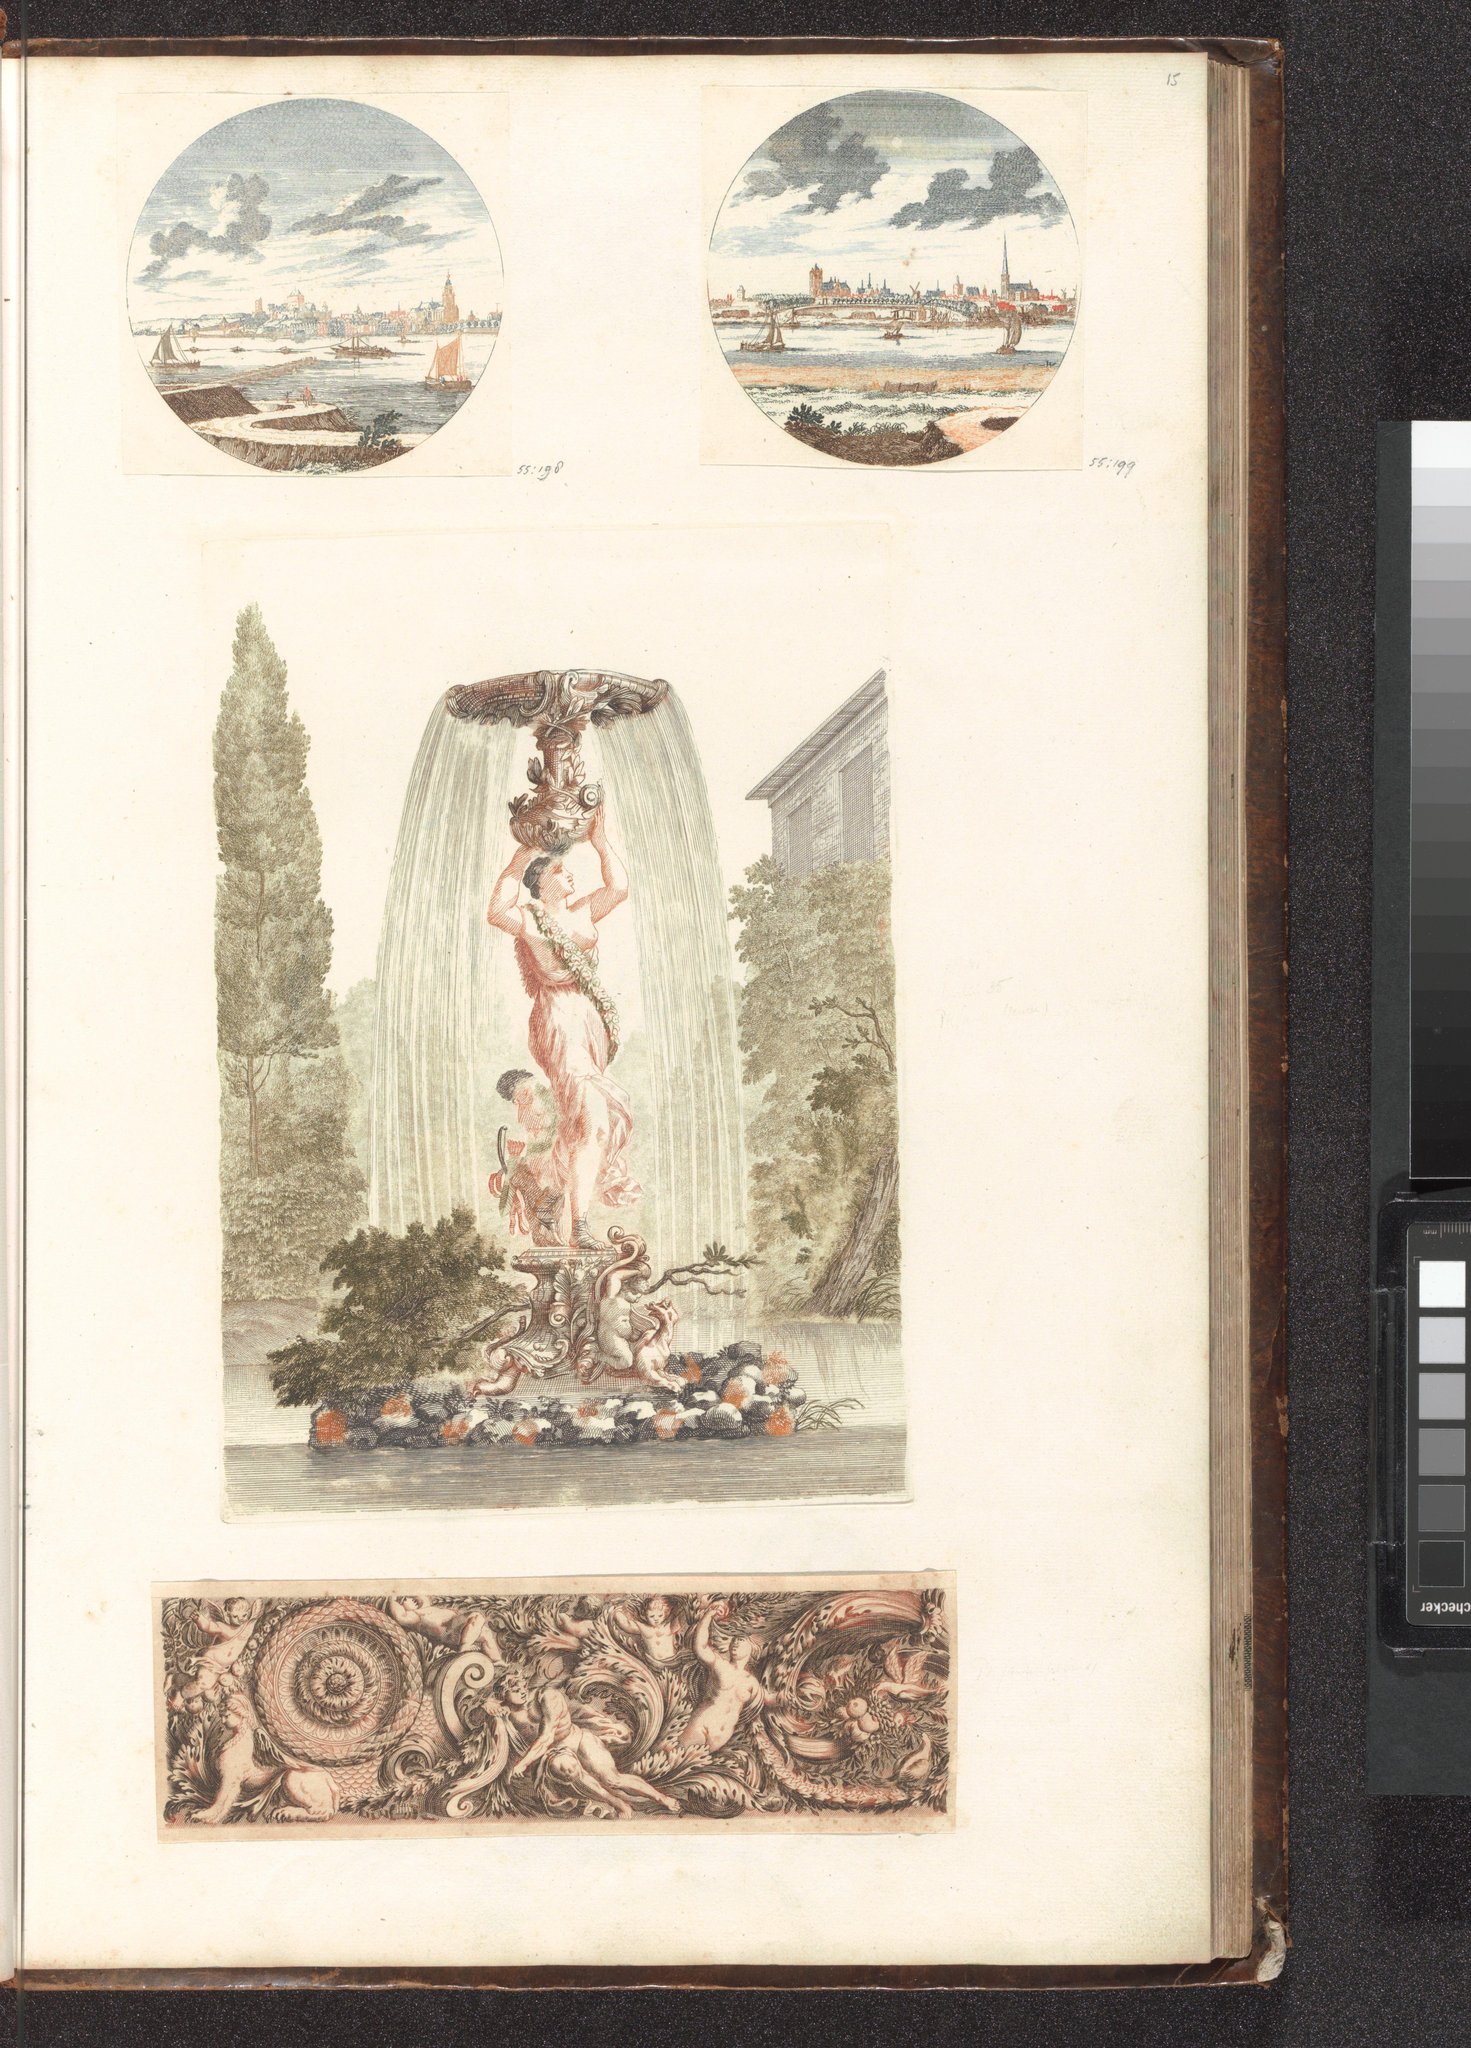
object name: album leaf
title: Ornamenteel fries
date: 1688-1698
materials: paper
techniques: printing, engraving, lithography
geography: netherlands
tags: rosette ~ ornament, sphinx (lion/woman); 'sfinge' (ripa), cupids: 'amores', 'amoretti', 'putti'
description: Fries met ornamentele plantmotieven, een sfinx, een naakte man- en vrouwfiguur, Amor en drie putti. Links een rozet. Deze prent maakt deel uit van een album.